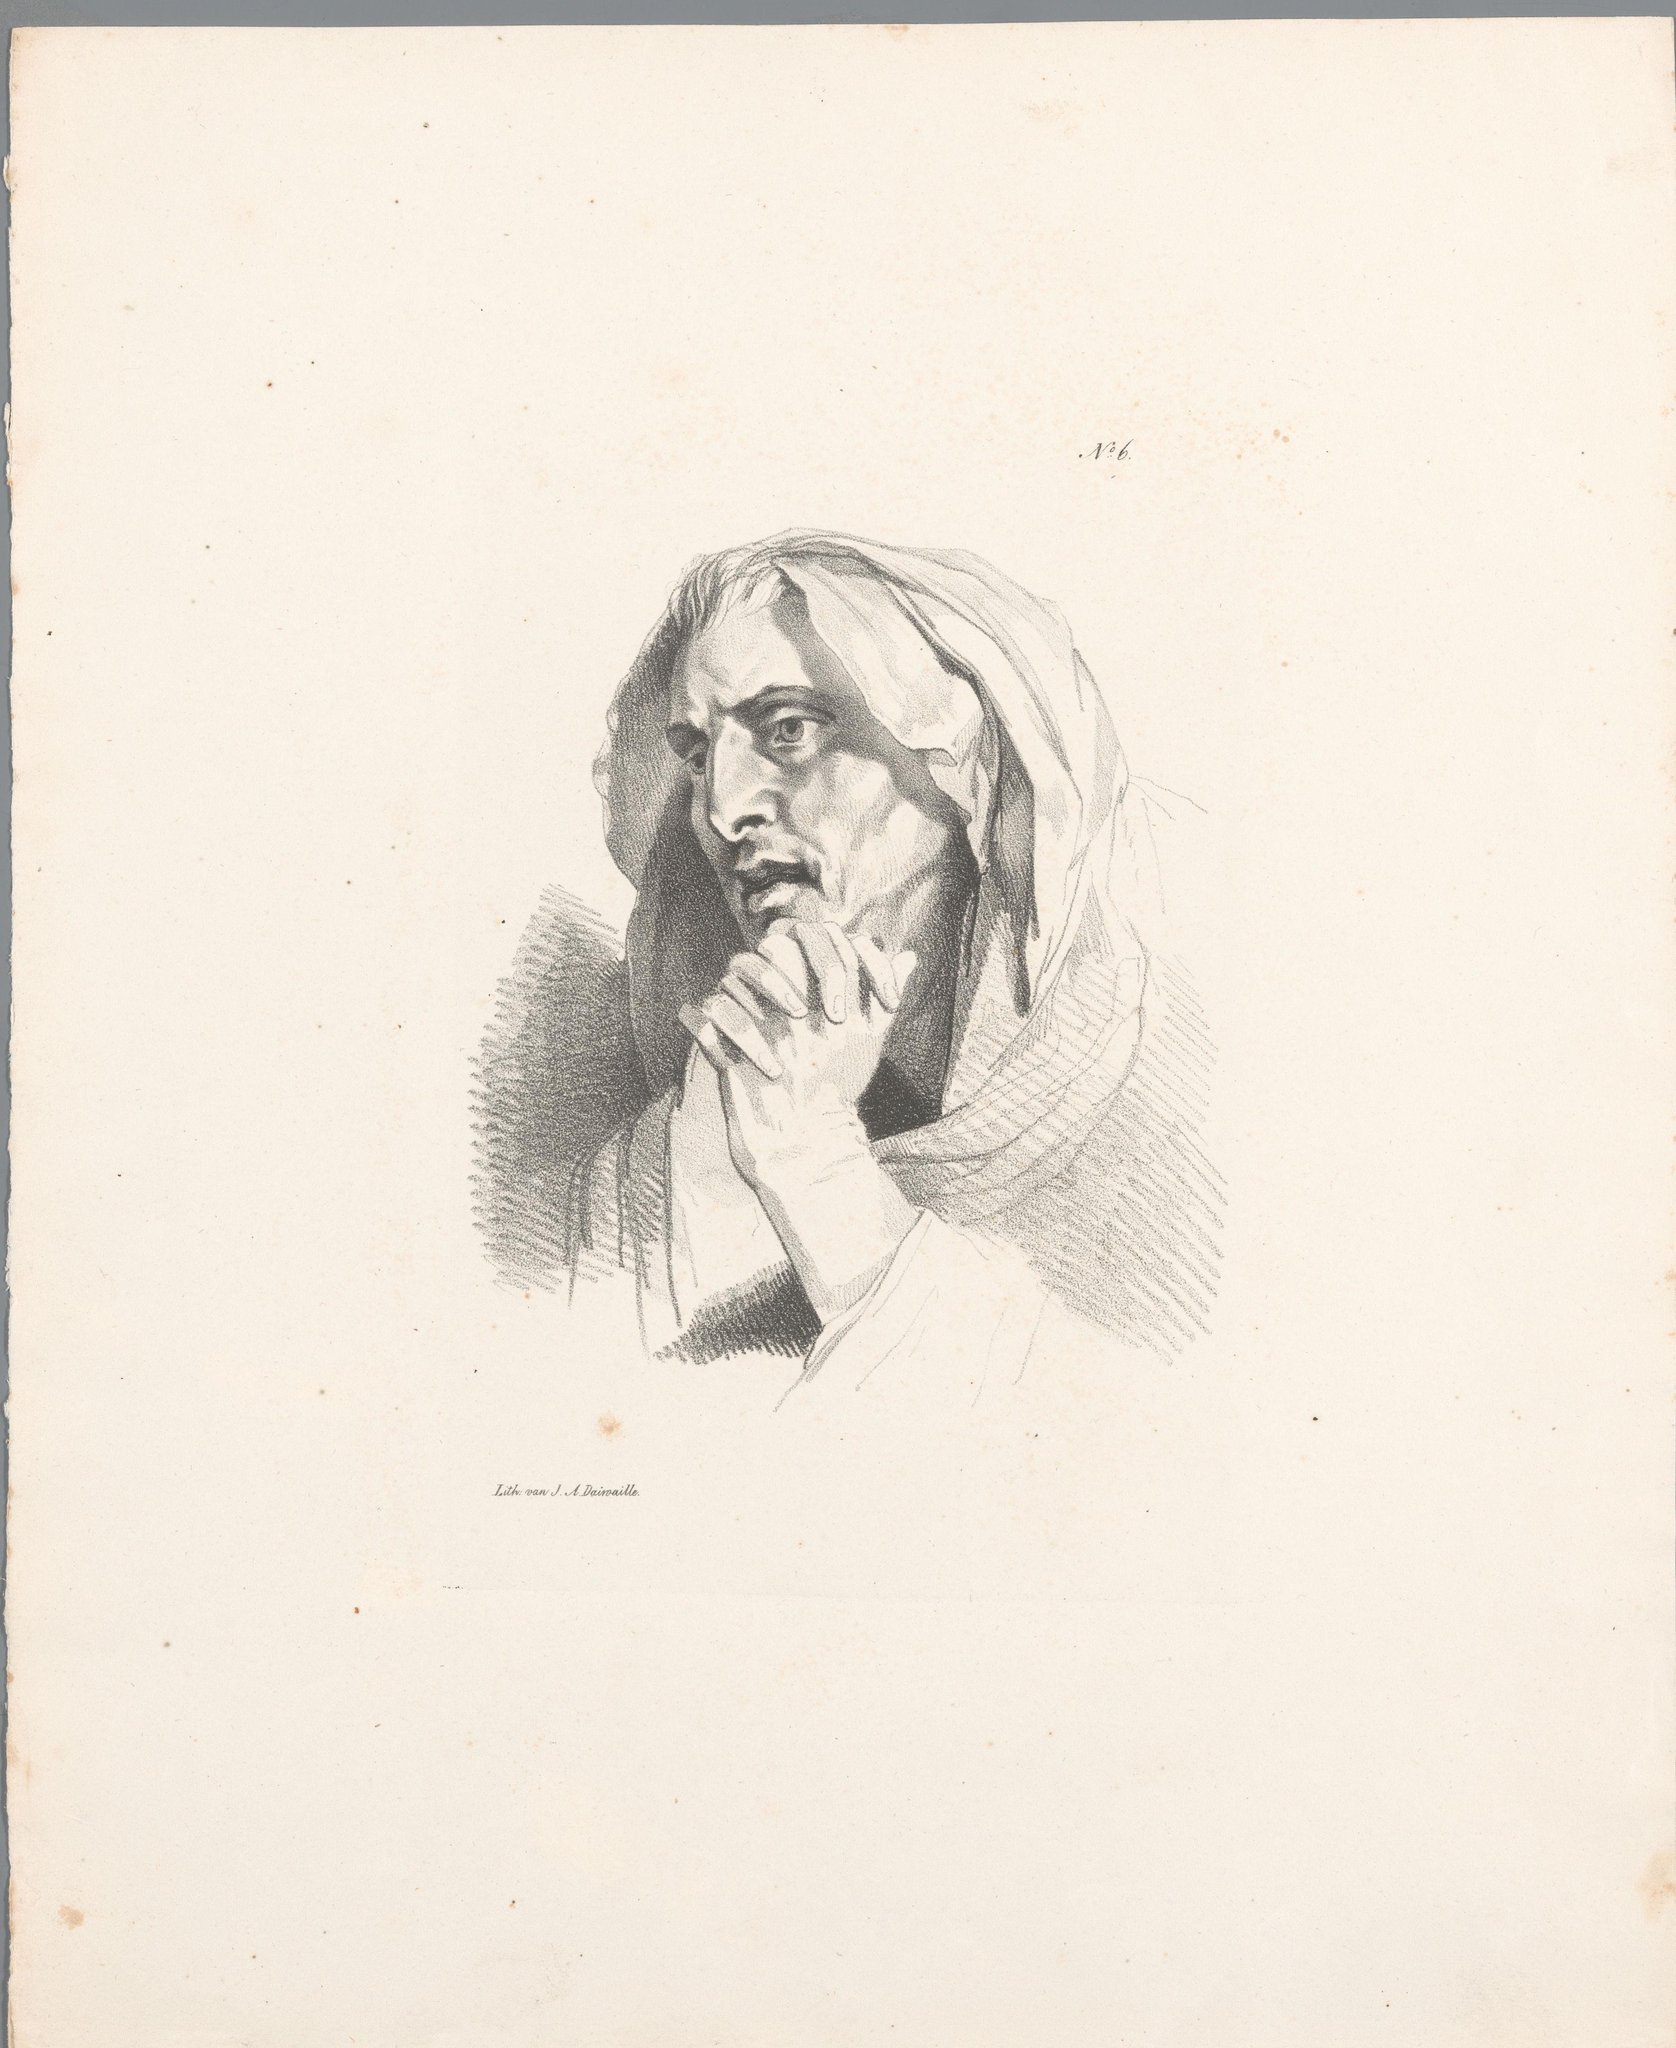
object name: print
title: Biddende man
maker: jean augustin daiwaille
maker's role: draughtsman, print maker, printer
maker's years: 1786-1850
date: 1820-1830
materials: paper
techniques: lithograph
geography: amsterdam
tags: head-gear (with name), one person praying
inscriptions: collector's mark: Lugt 2228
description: 'Hartstochten na J.B. Greuze' bestaat uit twee of drie genummerde reeksen. (Sommige nummers komen drie keer voor op drie verschillende afbeeldingen.) Binnen deze omslag bevinden zich achttien verschillende afbeeldingen. Mogelijk heeft dit te maken met de twee momenten waarop Daiwaille de reeks uitgaf, ten tijden van zijn directeurschap aan de Rijksakademie in Amsterdam en daarna als zelfstandige. De omslag behoort waarschijnlijk bij een van deze twee series. Zie Marres-Schretlen in het Bulletin van het Rijksmuseum.